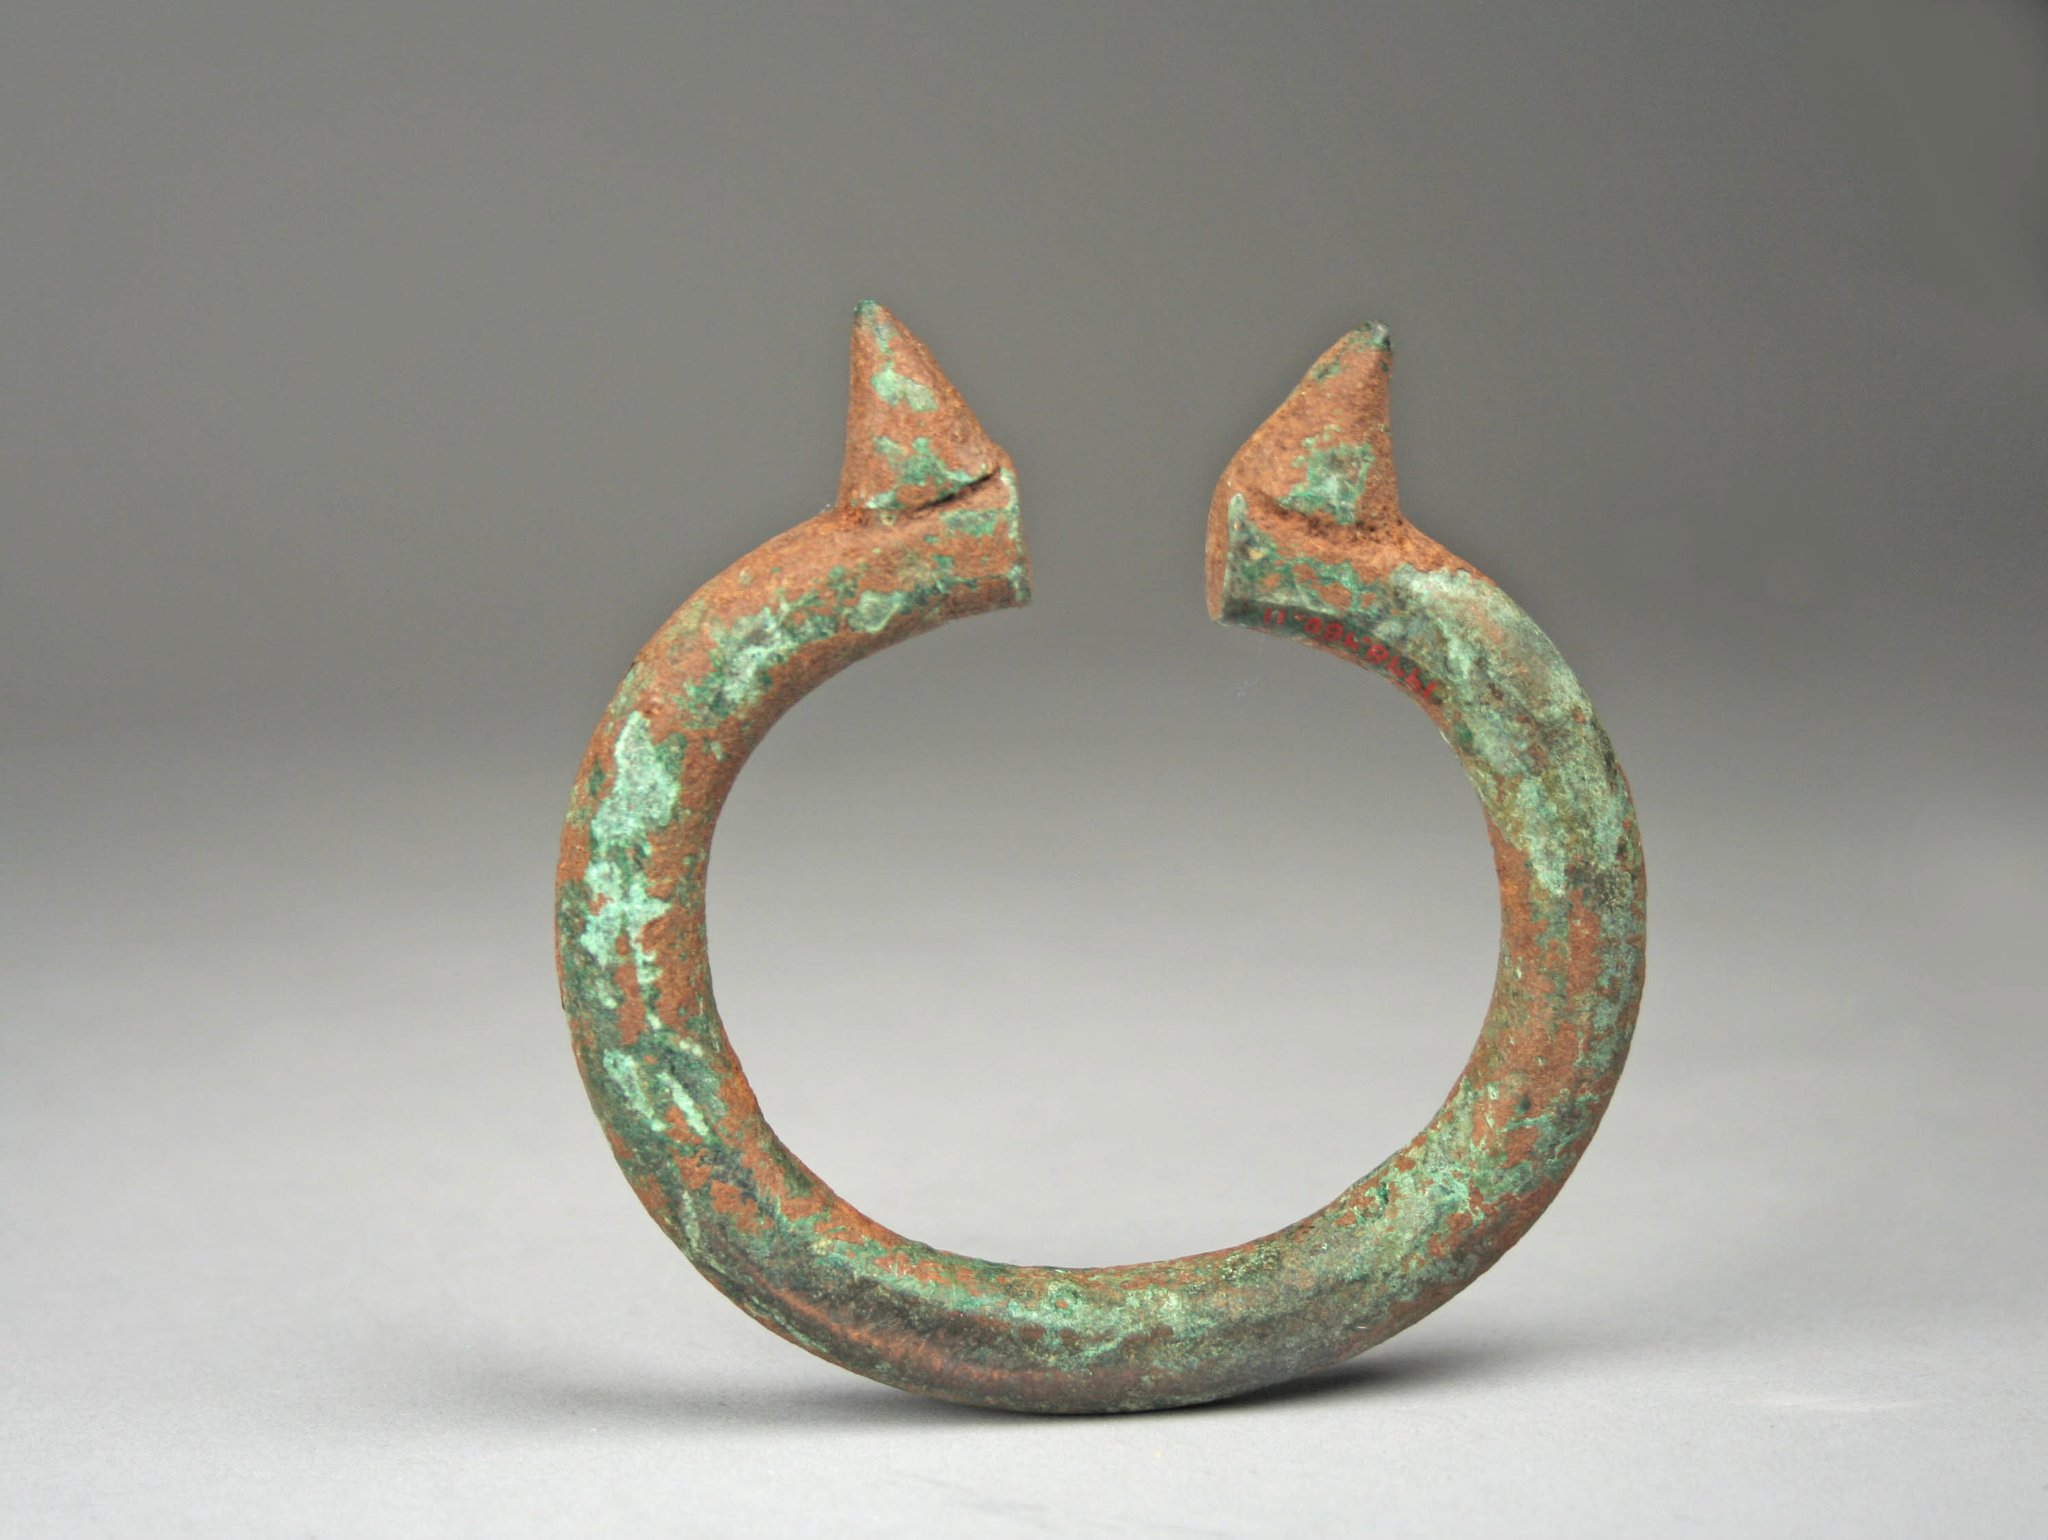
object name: bracelet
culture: middle niger civilization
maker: middle niger artist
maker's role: artist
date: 1301-1400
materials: copper alloy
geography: mali